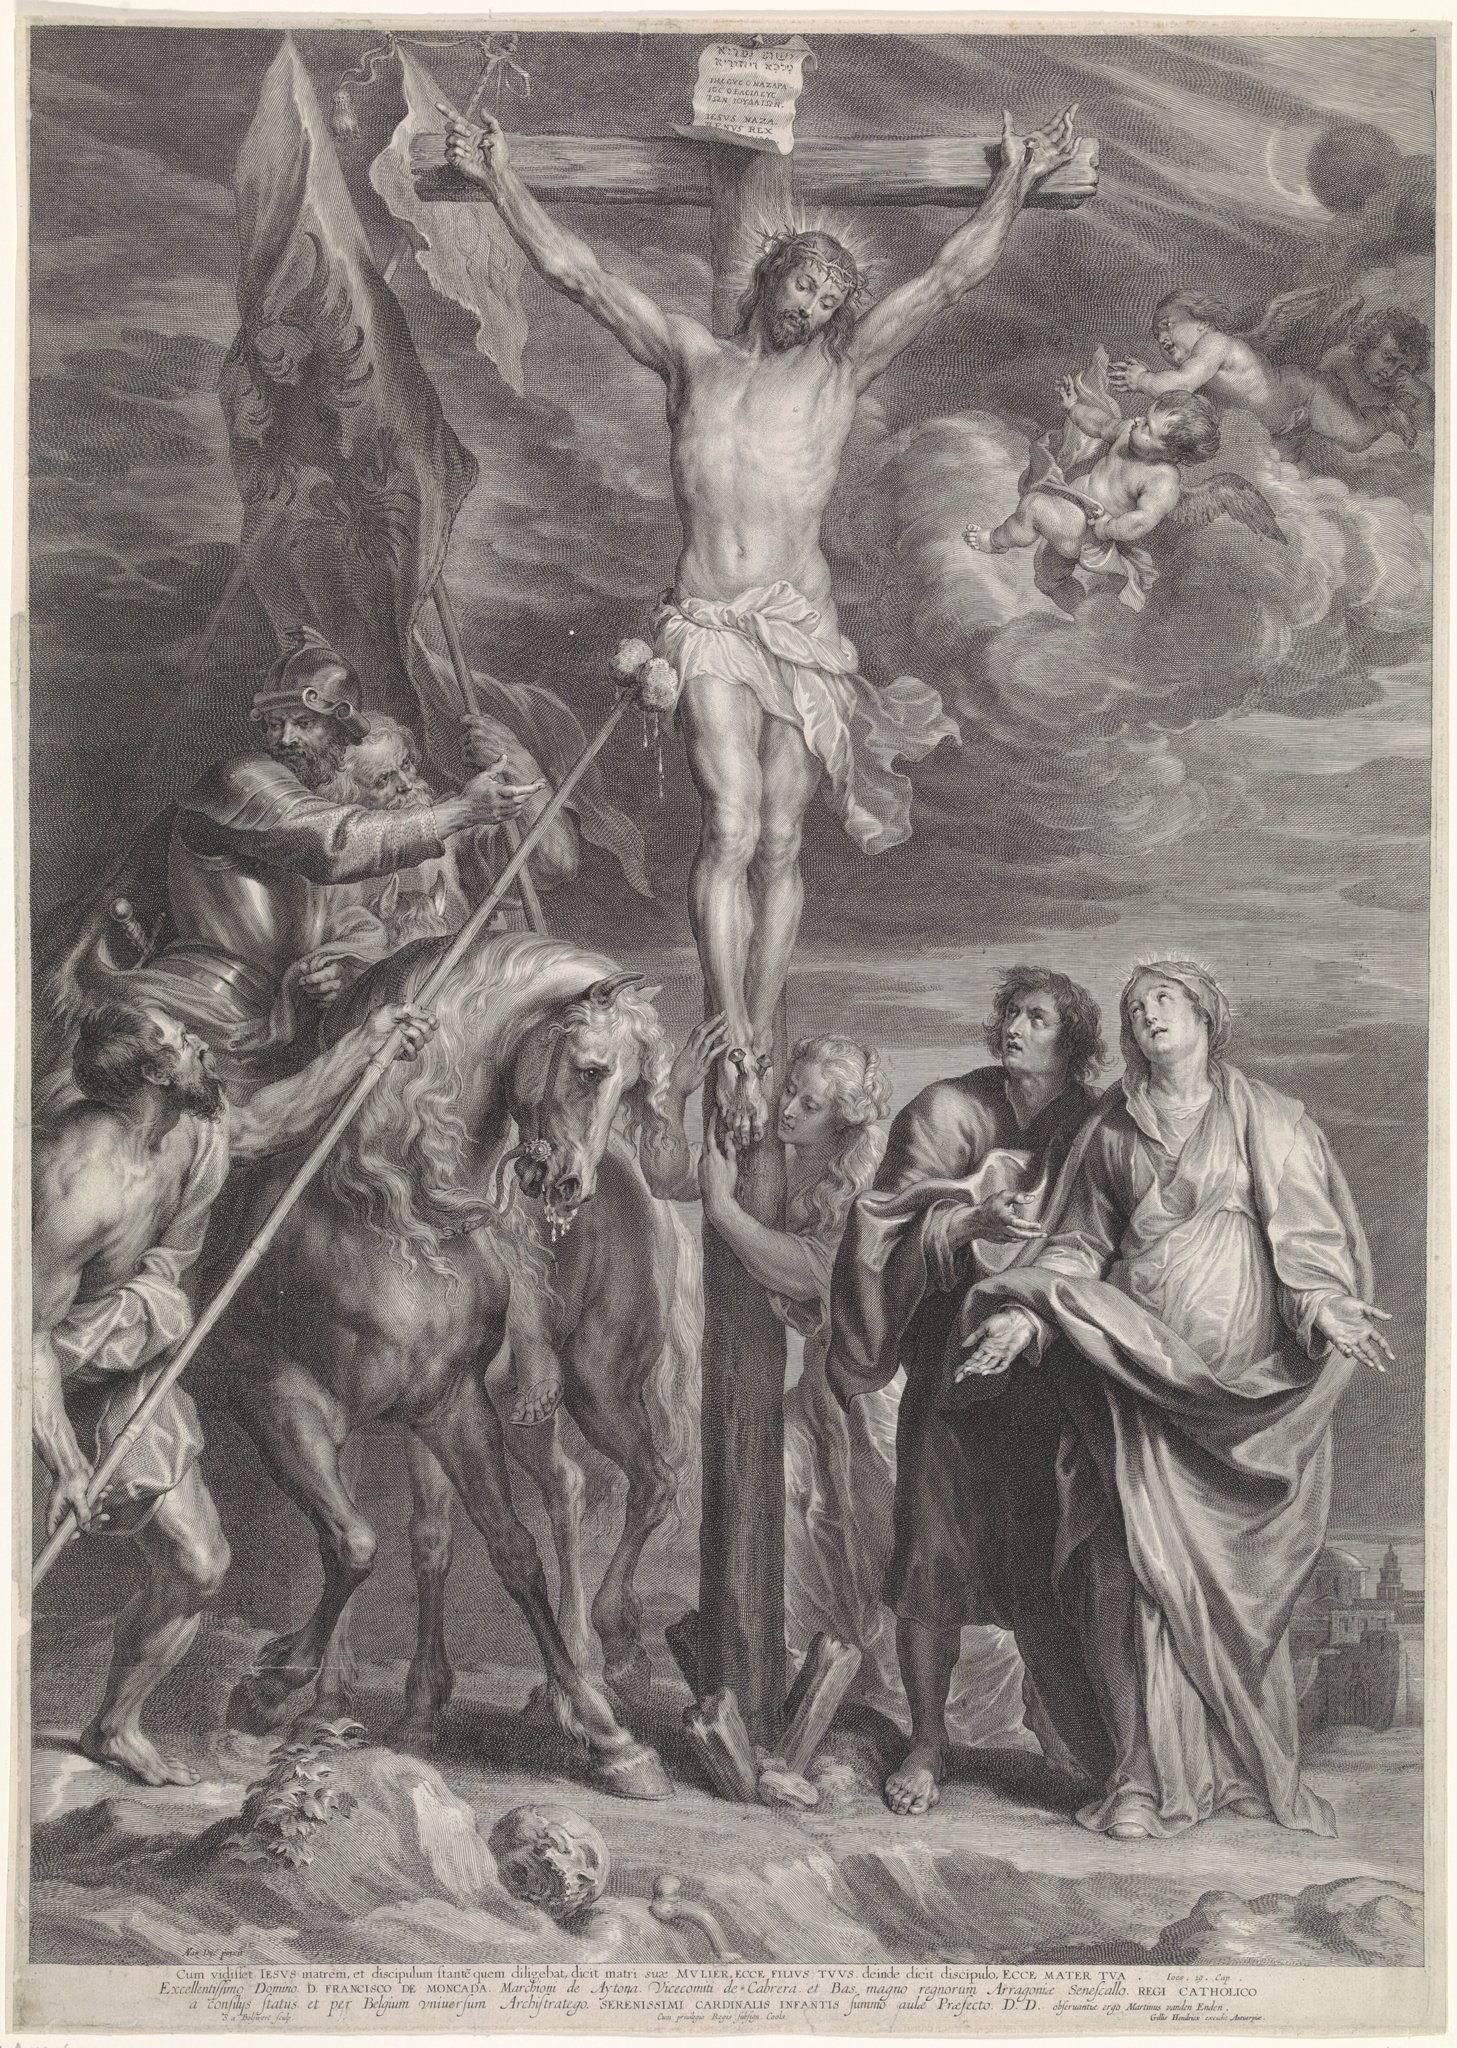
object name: print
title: Christus aan het kruis, met Maria, Johannes, Maria Magdalena en soldaten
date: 1596-1659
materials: paper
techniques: engraving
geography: netherlands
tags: crucified christ with mary, john, and mary magdalene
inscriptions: collector's mark: Lugt 2228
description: Prent naar schilderij van Anthony van Dyck. Opvallend verschil met voorgaande staten is het verwijderen van de hand van Johannes welke ruste op de schouder van Maria, zie Luijten 1999, p. 226.